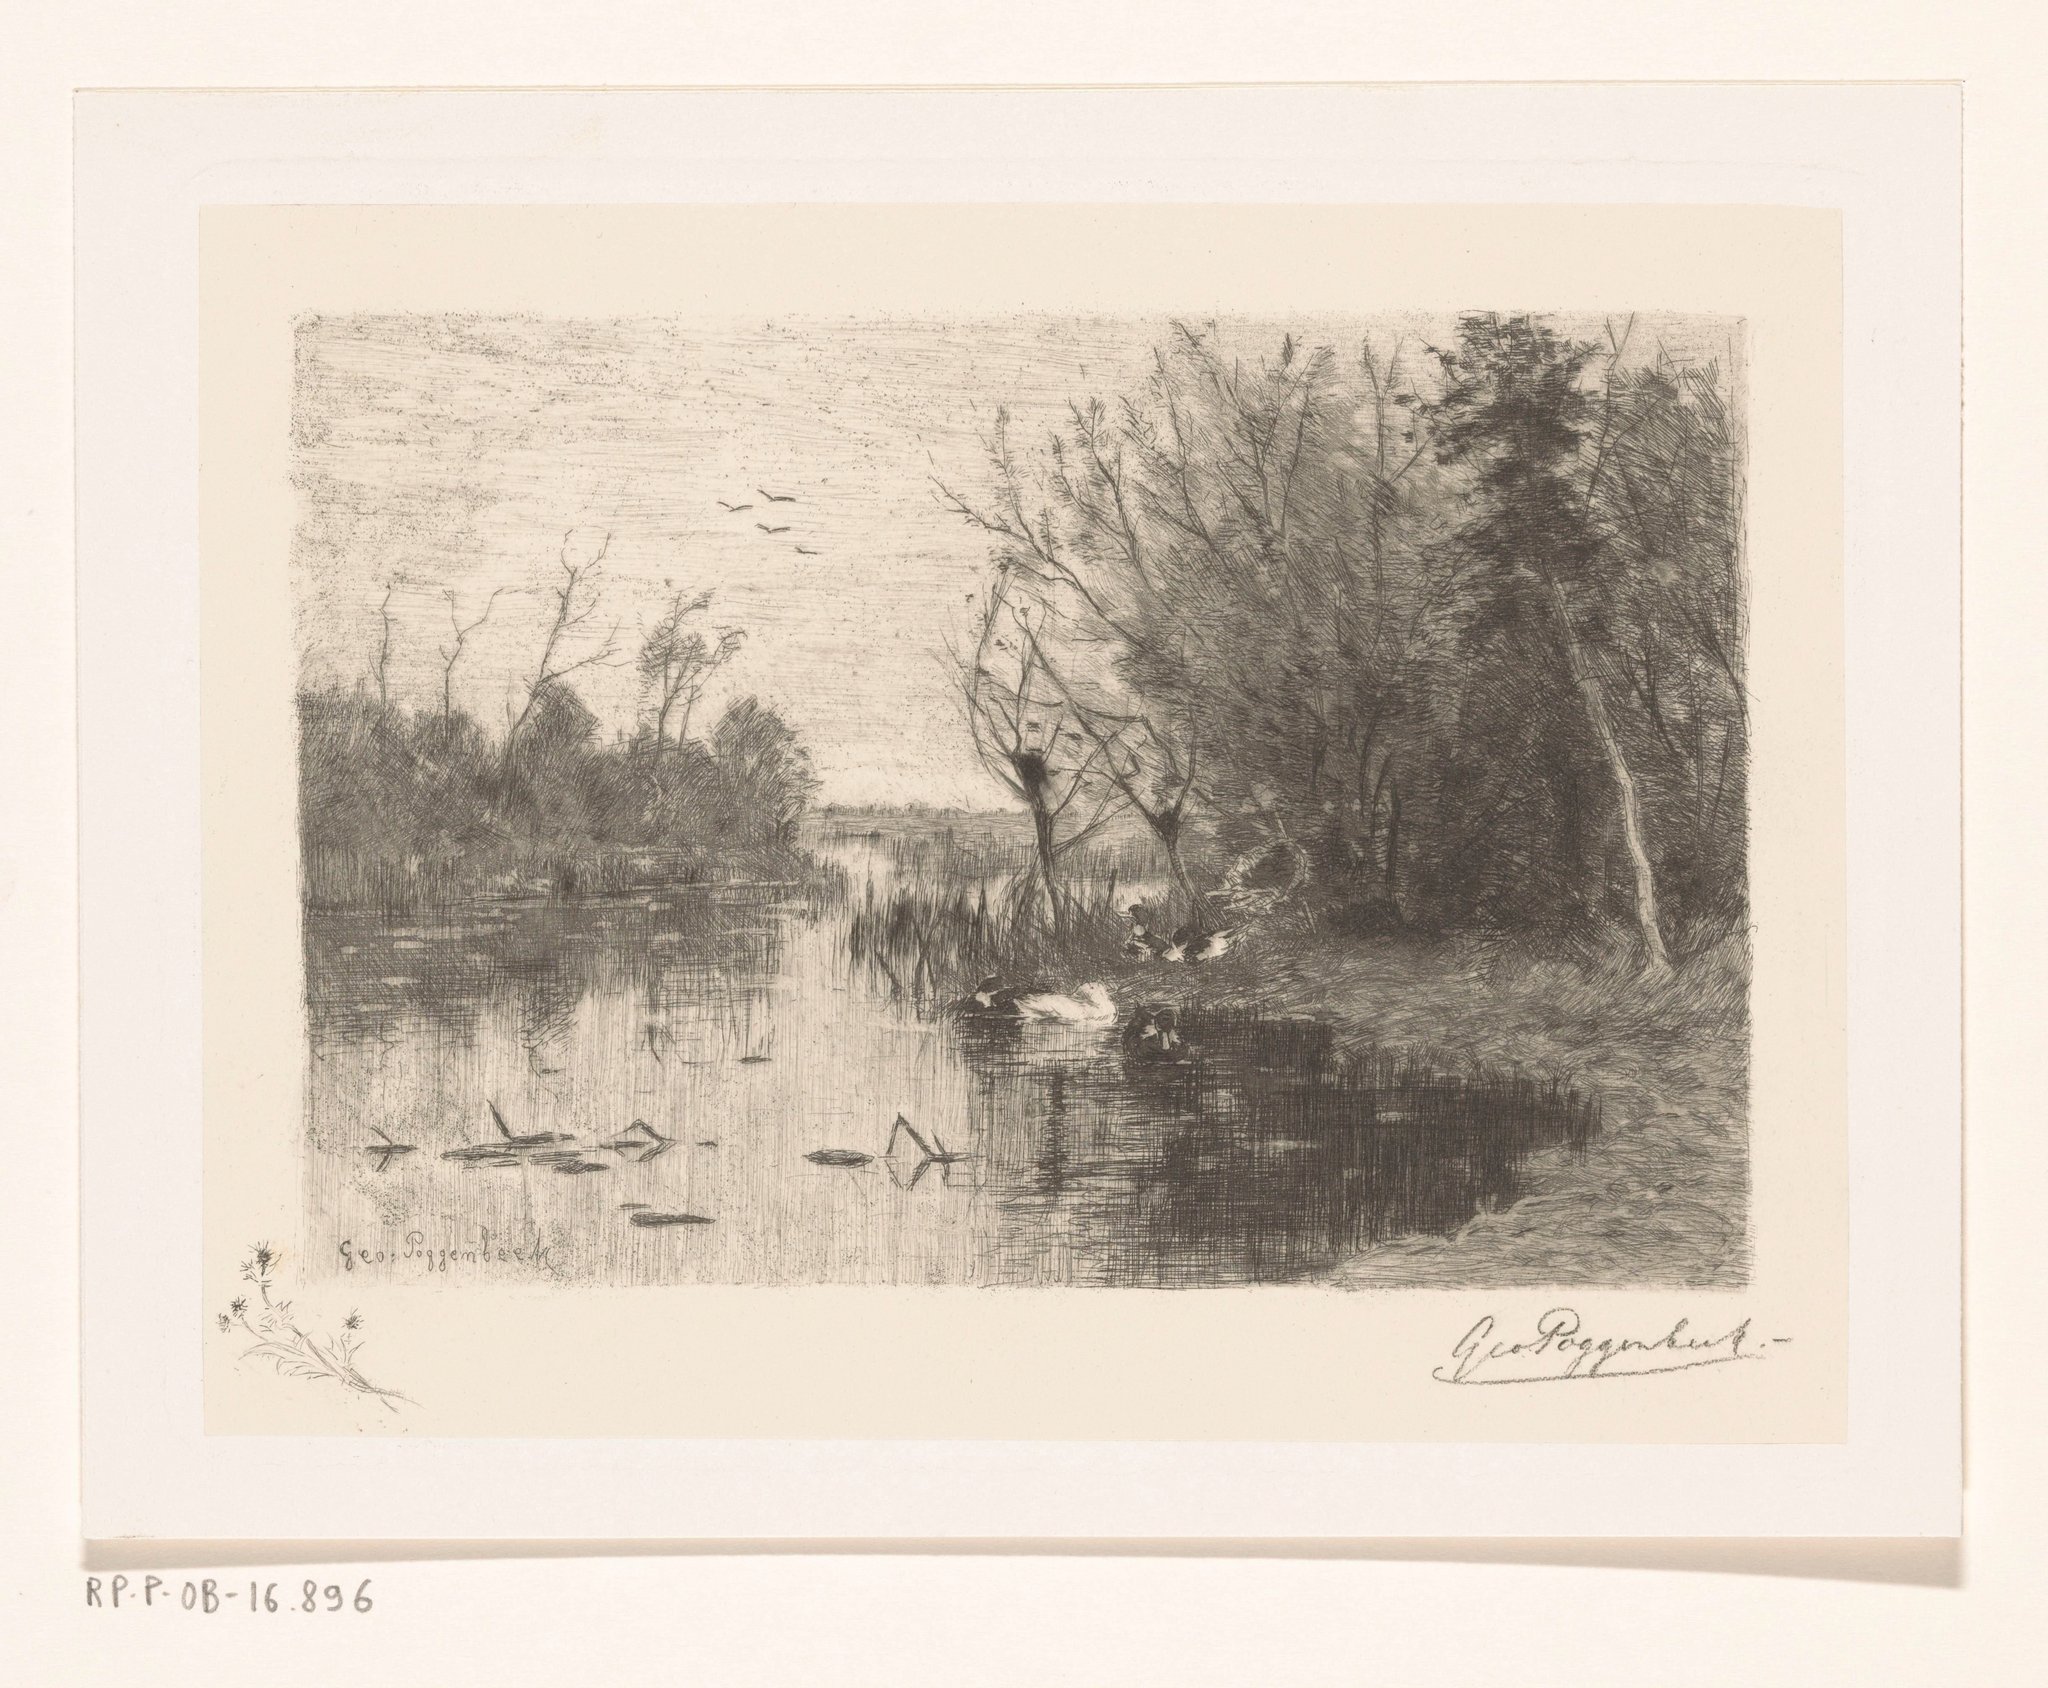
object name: print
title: Eendenplas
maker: geo poggenbeek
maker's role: draughtsman, painter, print maker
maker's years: 1853-1903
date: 1863-1903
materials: paper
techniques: etching, intaglio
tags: lake, water-birds: duck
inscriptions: collector's mark: Lugt 2228